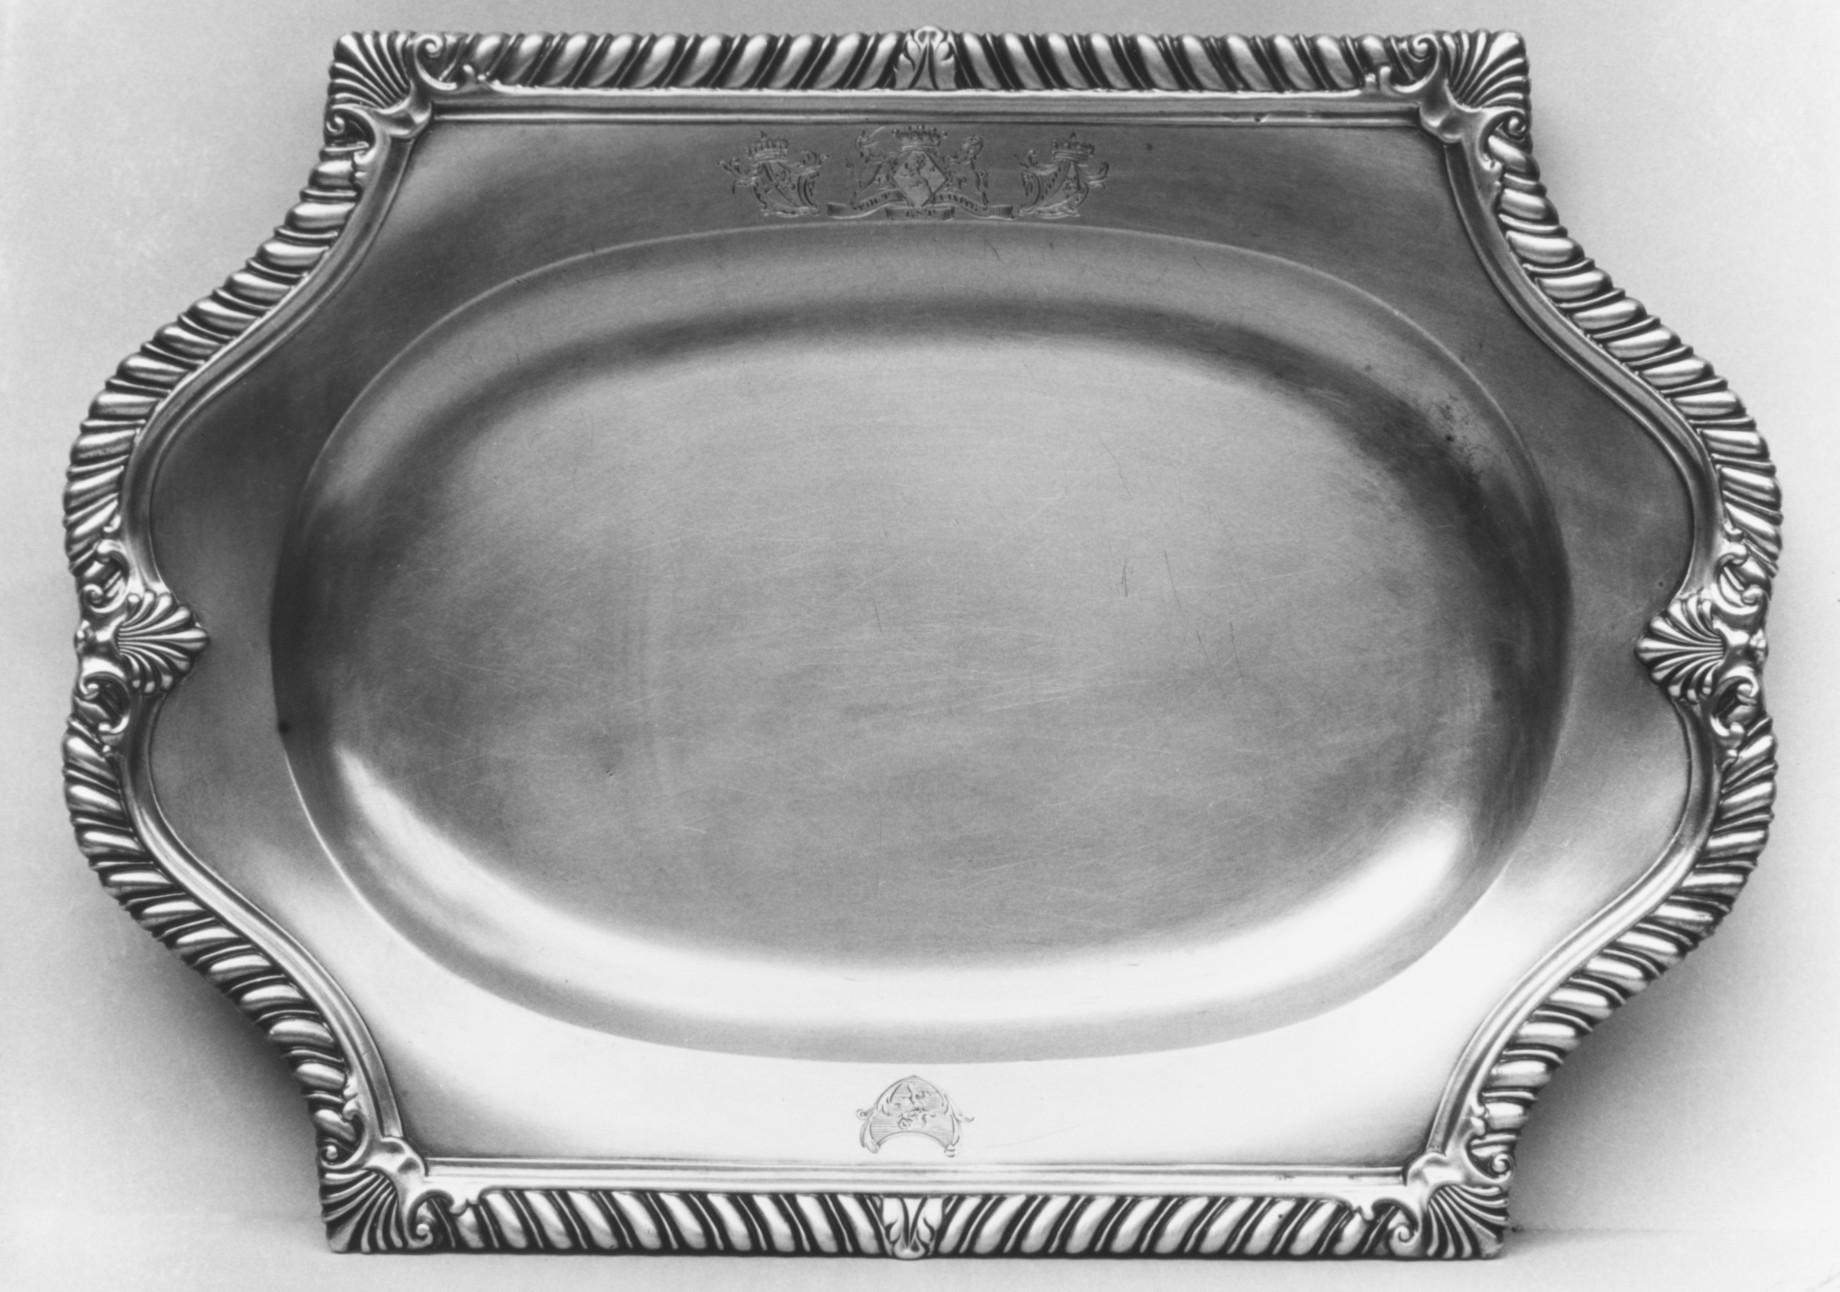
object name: dish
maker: paul de lamerie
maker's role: maker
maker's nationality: british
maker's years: 1688-1751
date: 1745-1746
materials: silver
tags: coat of arms